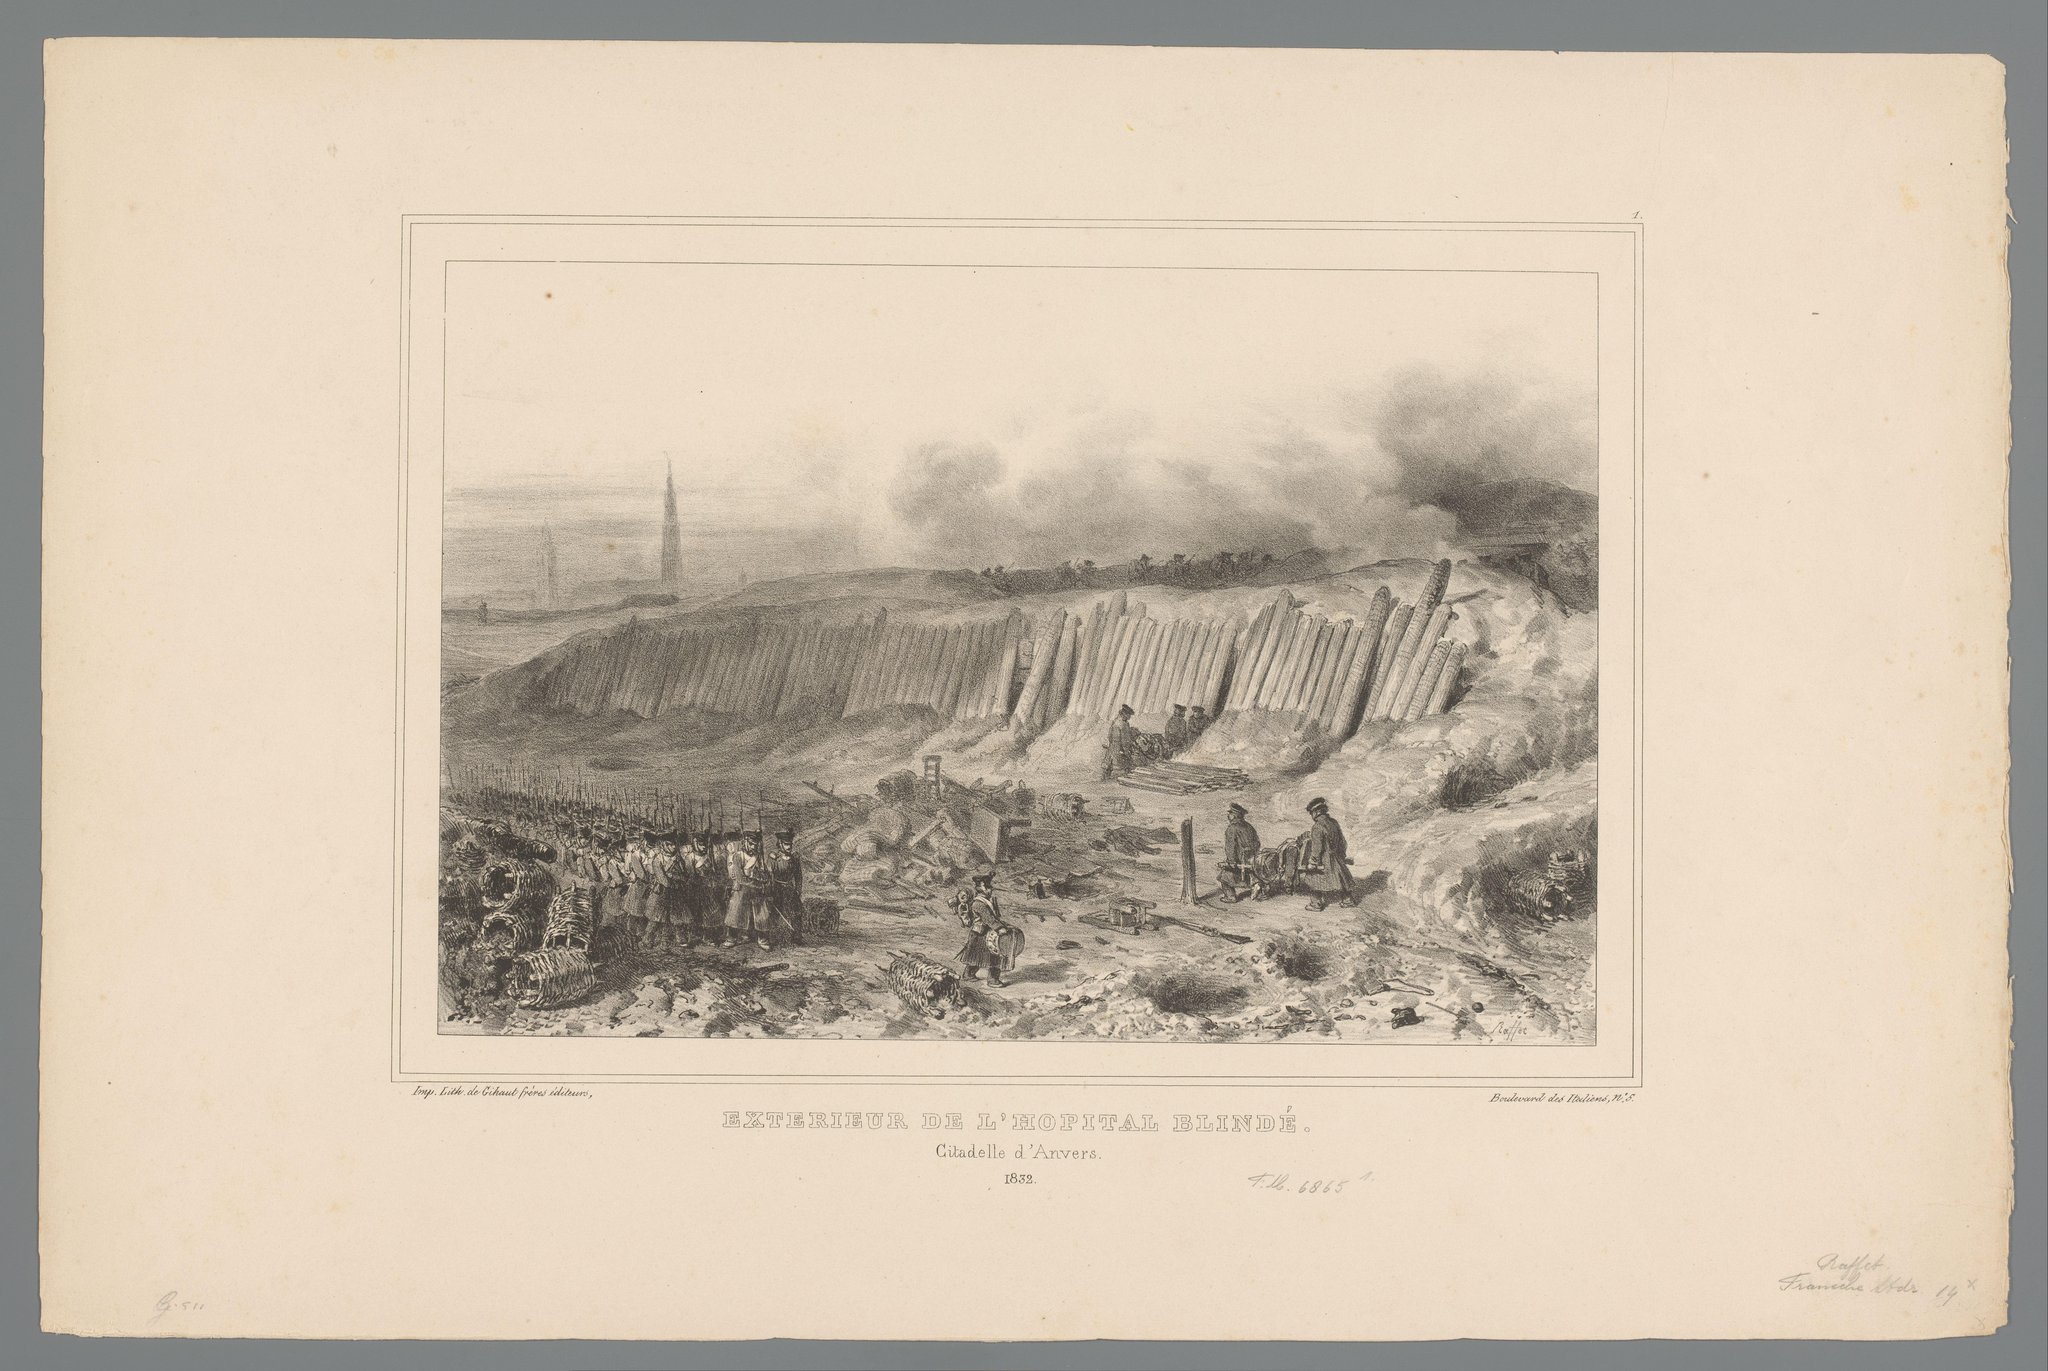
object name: print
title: Exterieur de l'hopital blindé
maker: denis auguste marie raffet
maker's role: draughtsman, print maker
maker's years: 1804-1860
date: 1833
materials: paper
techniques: lithograph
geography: paris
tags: medical aid and nursing of the sick and wounded in a field-hospital, the soldier; the soldier's life, antwerp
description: De buitenzijde van het ingegraven veldhospitaal van de Citadel van Antwerpen. Links een regiment soldaten. Onderdeel van de serie van 24 prenten over het beleg van de Citadel van Antwerpen, 30 november - 23 december 1832.